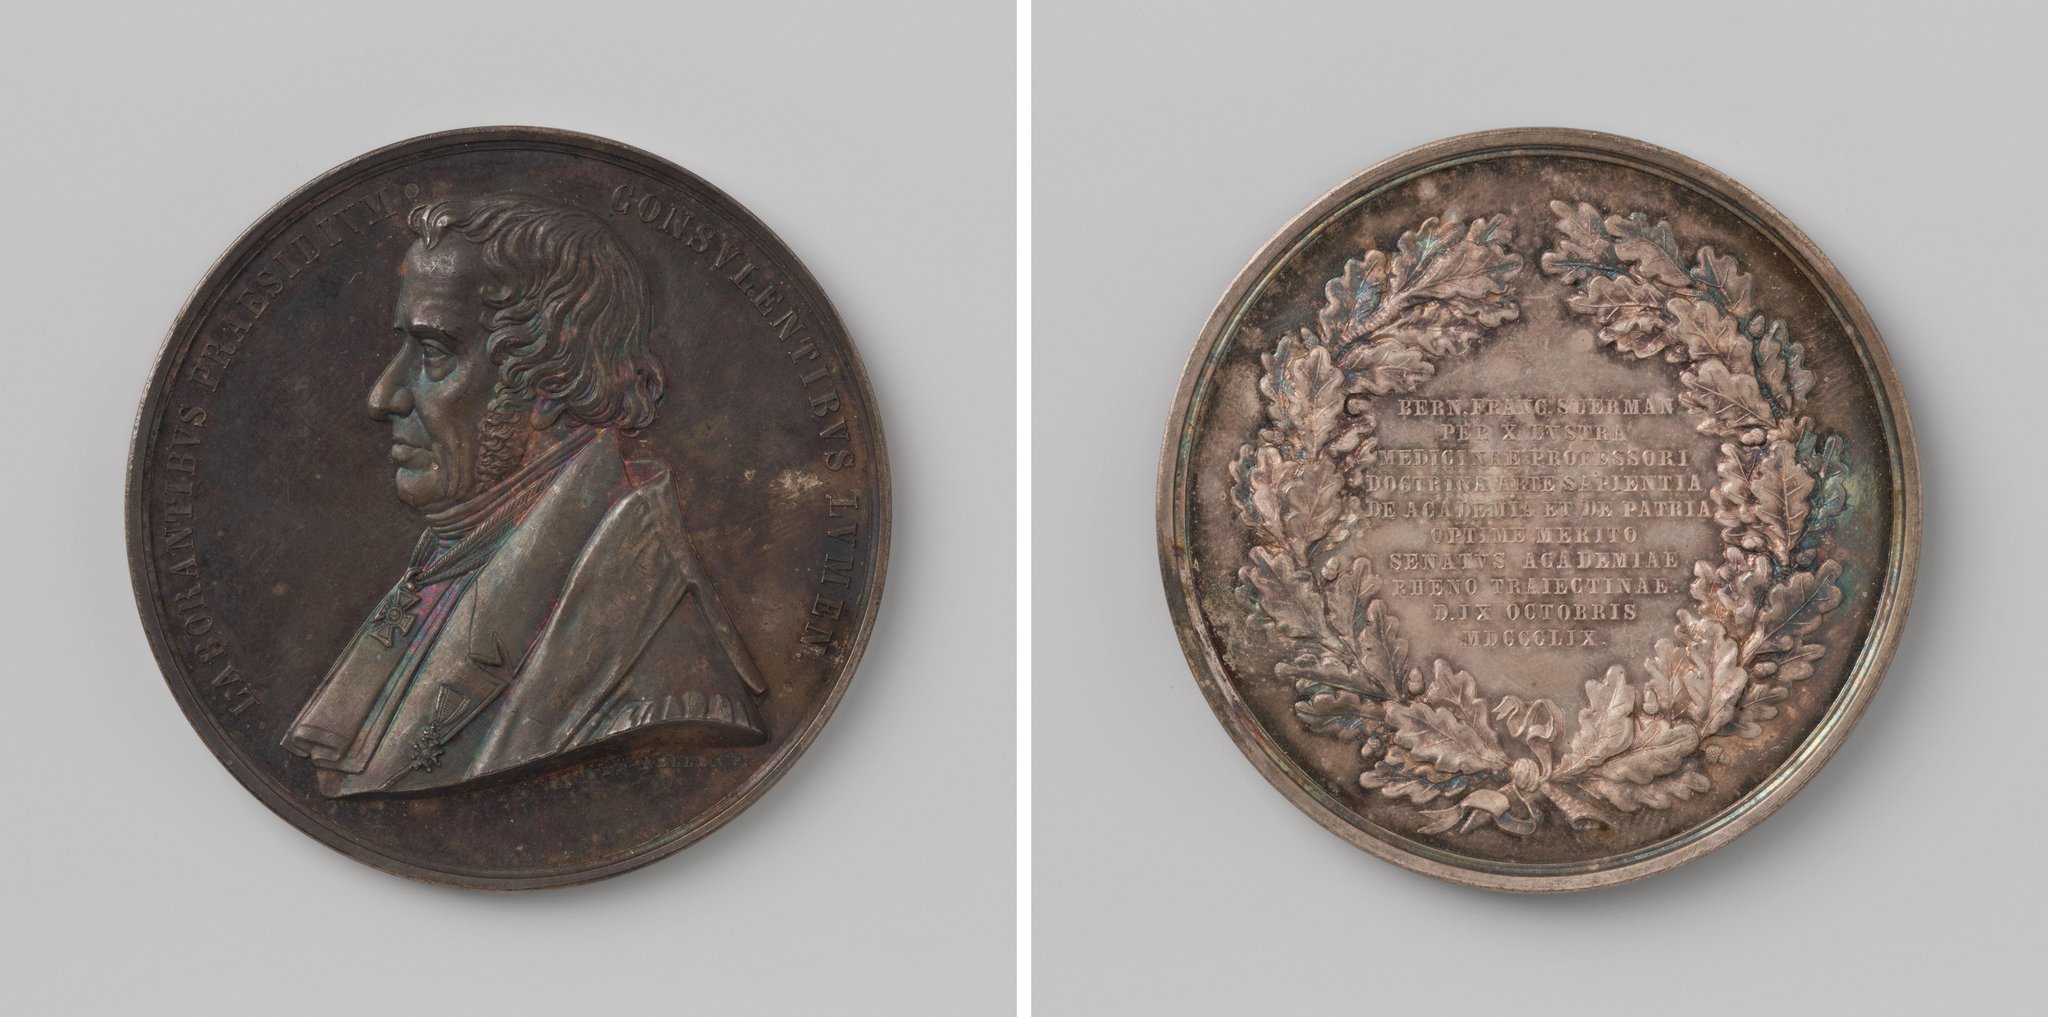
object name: honorary medal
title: Bernardus Franciscus Suerman, vijftig jaar hoogleraar in de geneeskunde aan de universiteit van Utrecht, penning geslagen op last van de Senaat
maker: david van der kellen (1804-1879)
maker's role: die cutter, draughtsman, print maker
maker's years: 1804-1879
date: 1859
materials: silver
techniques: striking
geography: utrecht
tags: haarlem, utrecht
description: Zilveren penning. Voorzijde: borststuk man binnen omschrift. Keerzijde: opschrift binnen eikekrans